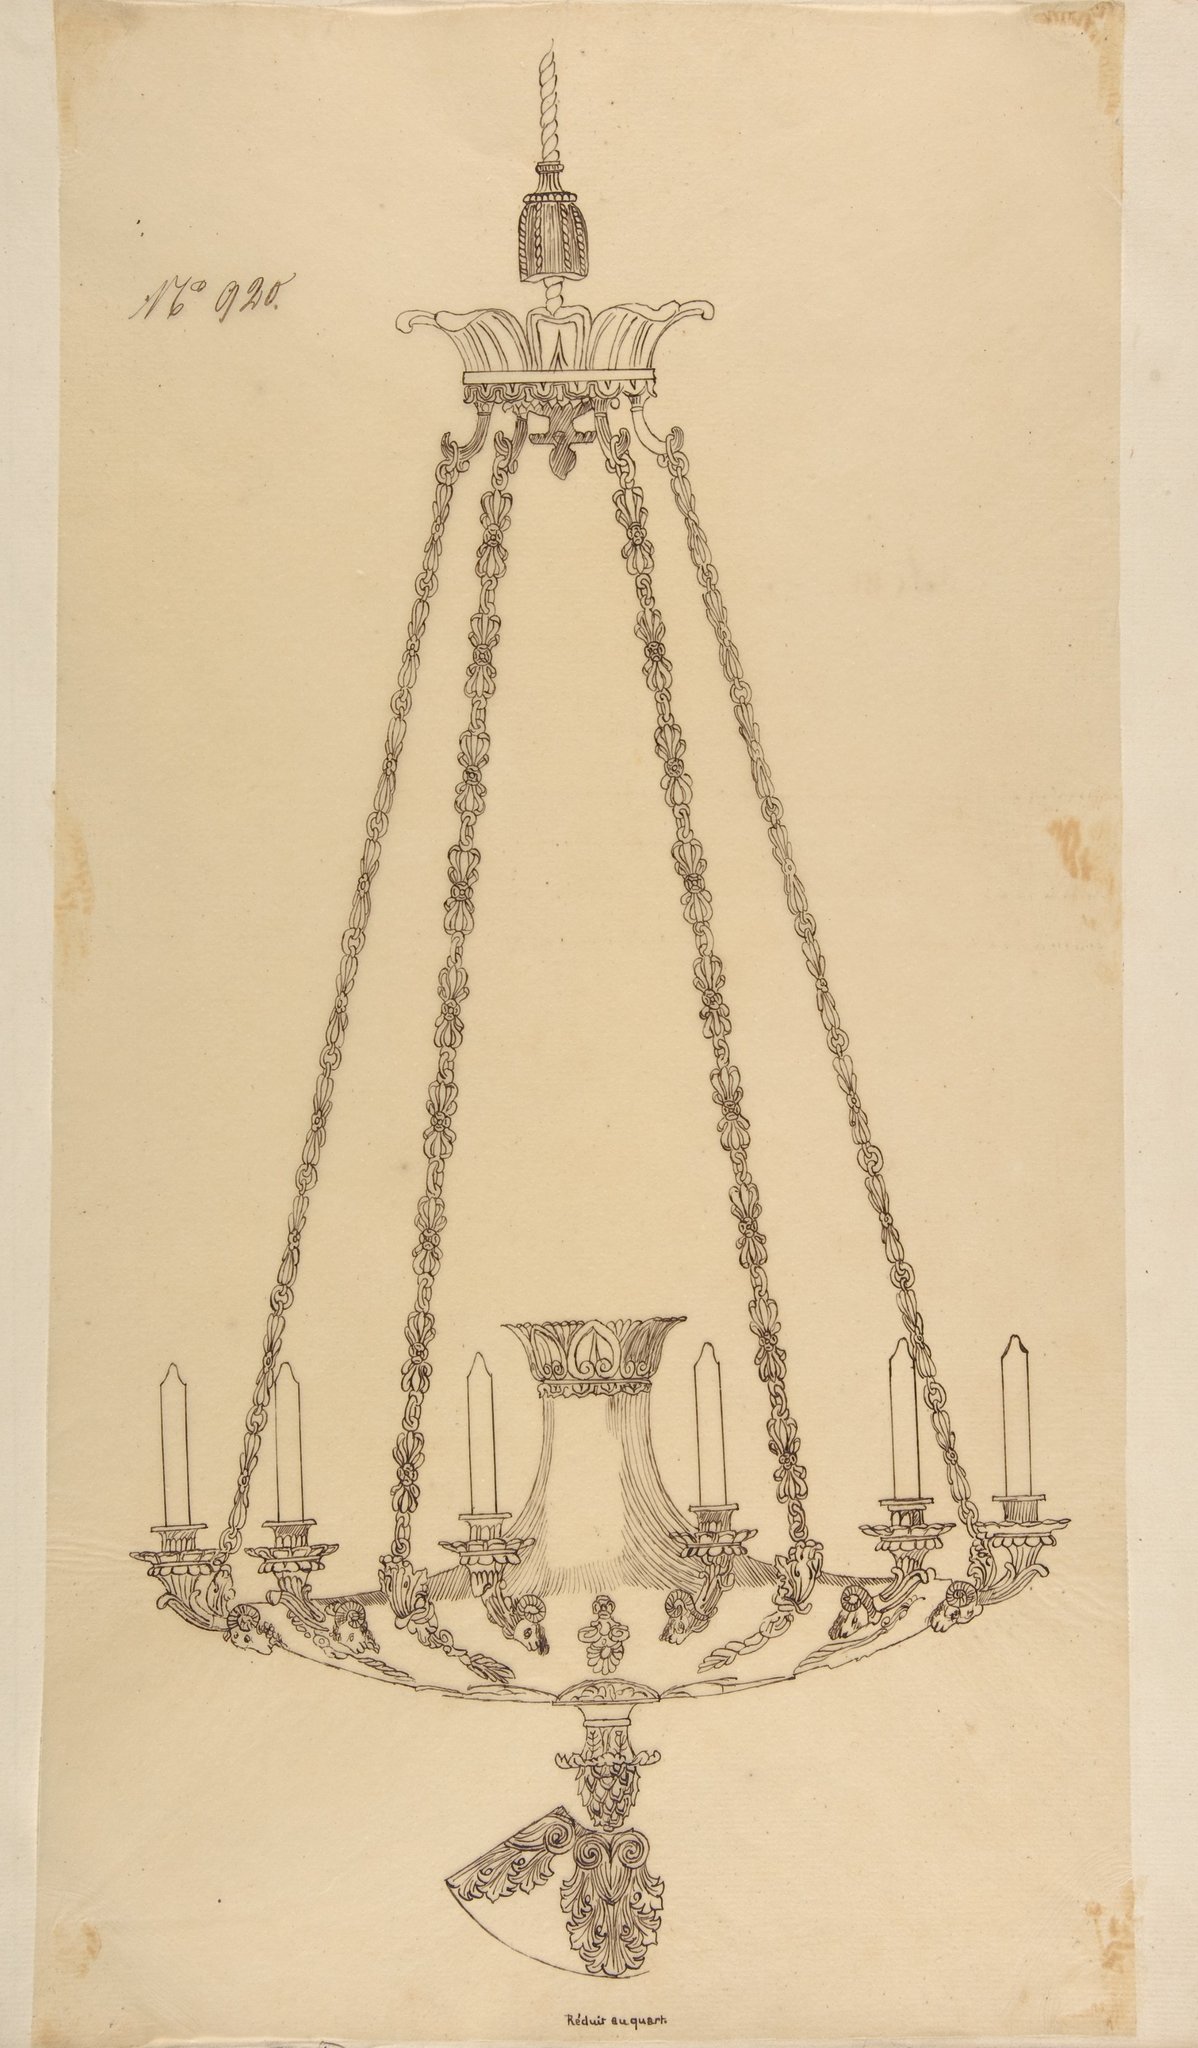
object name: drawing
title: Design for a Chandelier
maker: anonymous, french, 19th century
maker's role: artist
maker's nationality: french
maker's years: 1800-1900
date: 1801-1900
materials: ink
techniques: pen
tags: chandelier